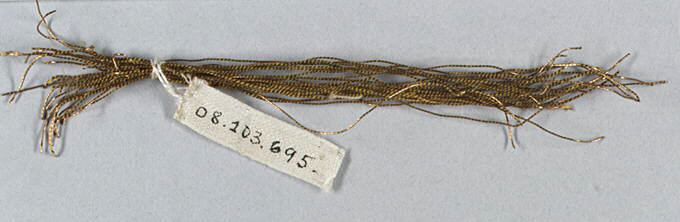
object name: thread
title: Tinsel and metal thread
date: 1701-1900